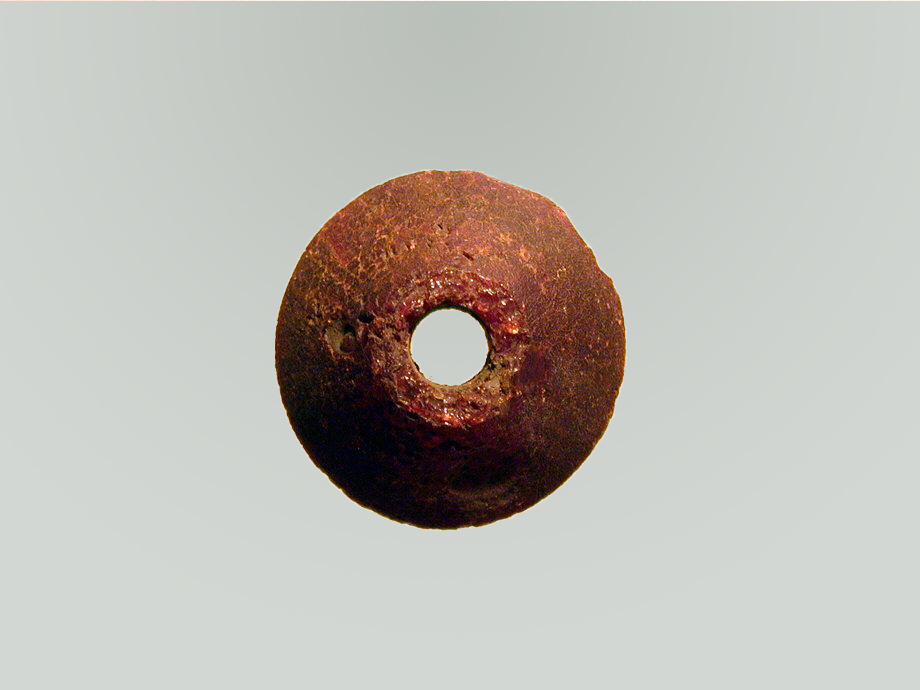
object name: whorl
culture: etruscan or italic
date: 700-601 BCE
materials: amber